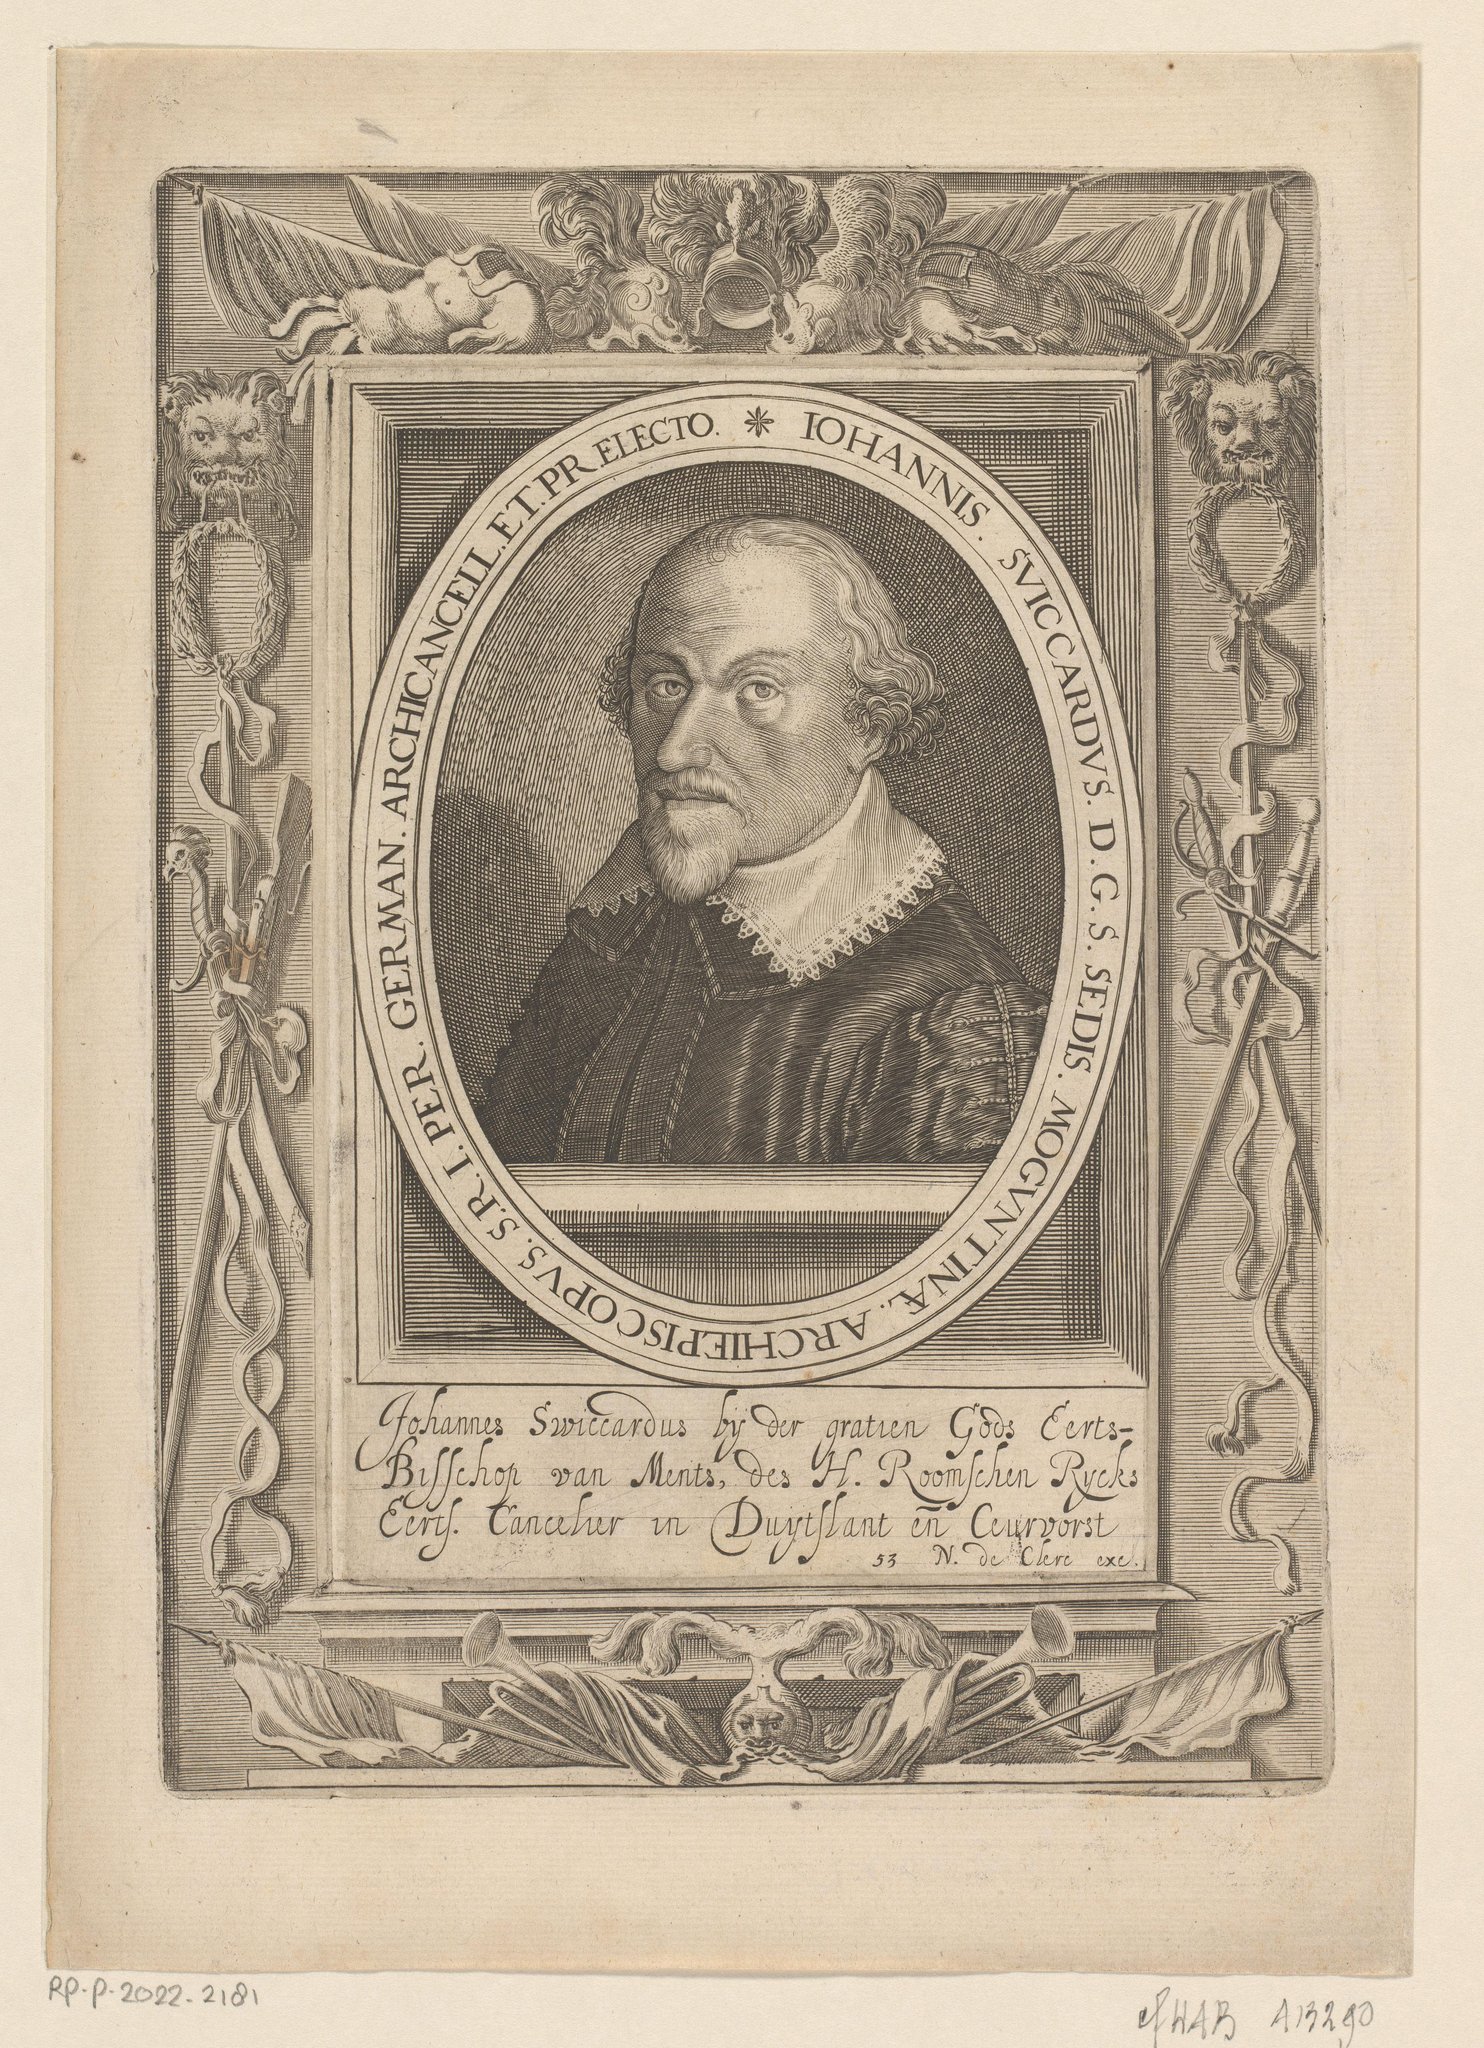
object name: print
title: Portret van Johann Schweikhard von Kronberg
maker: Anonymous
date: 1625-1640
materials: paper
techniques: engraving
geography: delft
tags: johann schweikhard von kronberg, archbishop, bishop, etc. (roman catholic), historical persons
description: Prent met andere omlijsting gebruikt in: Meteren, Emanuel van. Meteranus novus, das ist: warhafftige Beschreibung dess Niederländischen Krieges (...). Amsterdam: Johan Jansson, 1640.